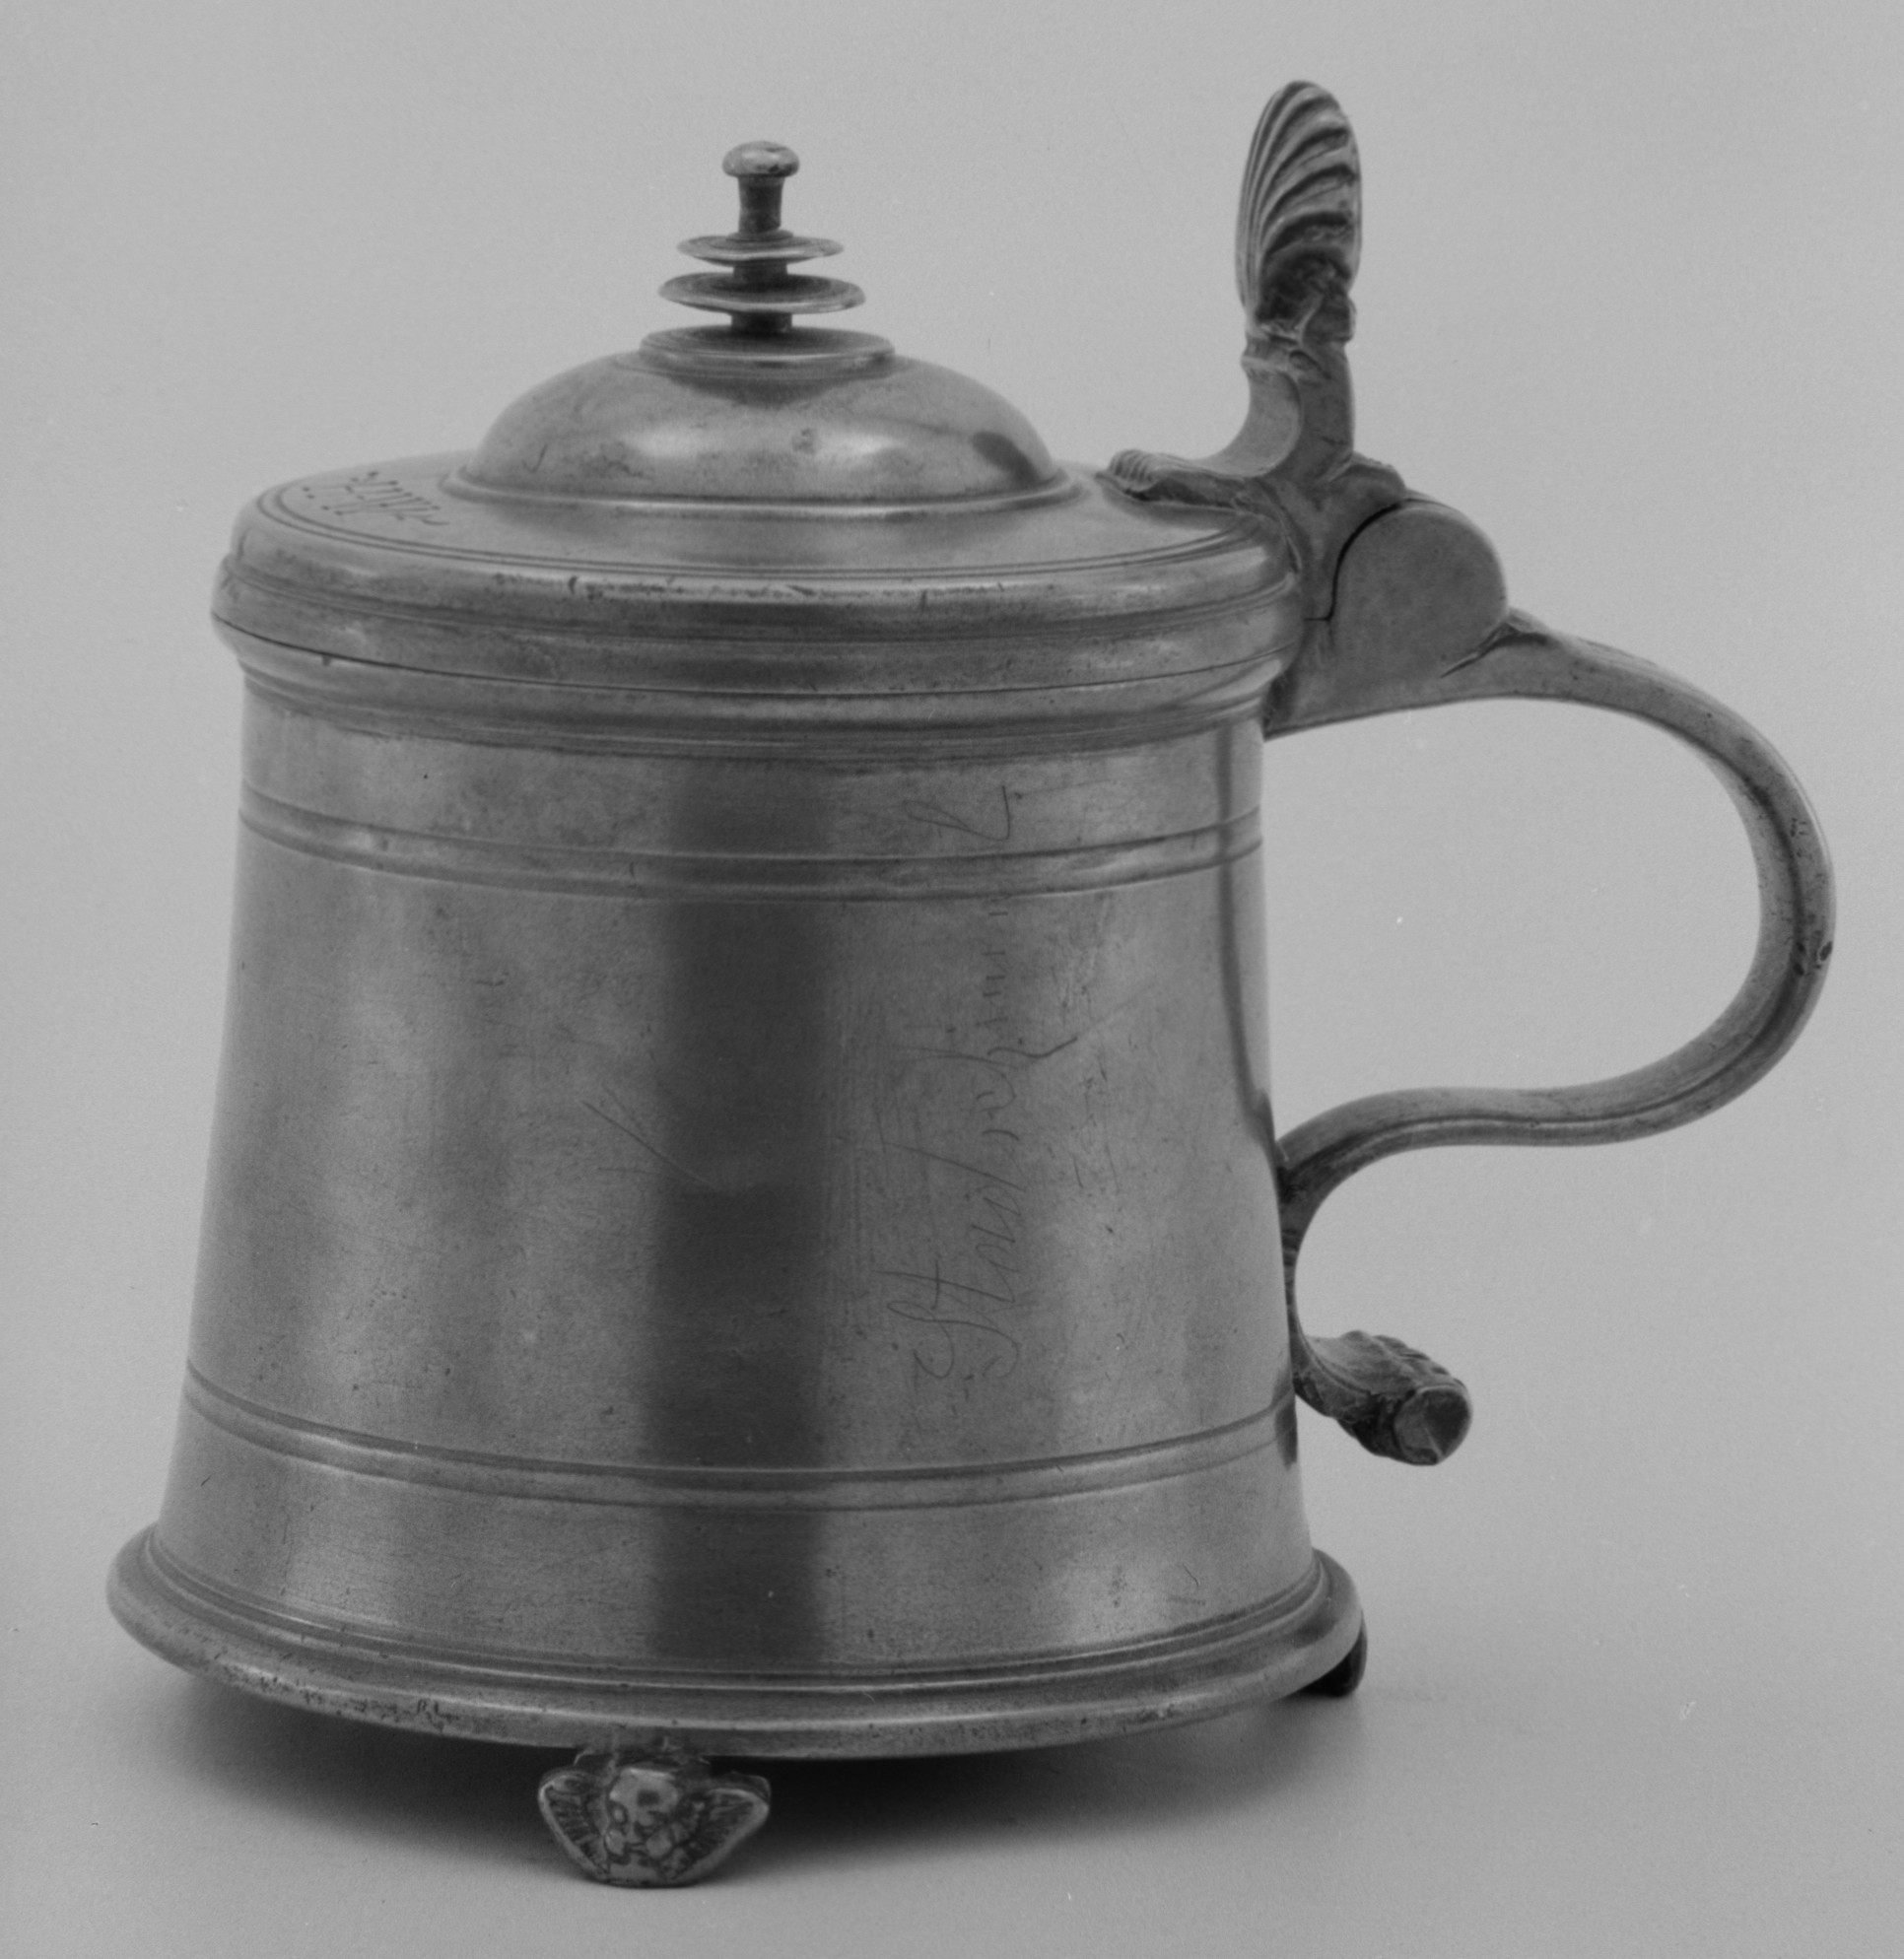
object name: tankard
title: Footed tankard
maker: christoph pfannenstill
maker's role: maker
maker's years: 1625-1725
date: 1666-1699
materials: pewter